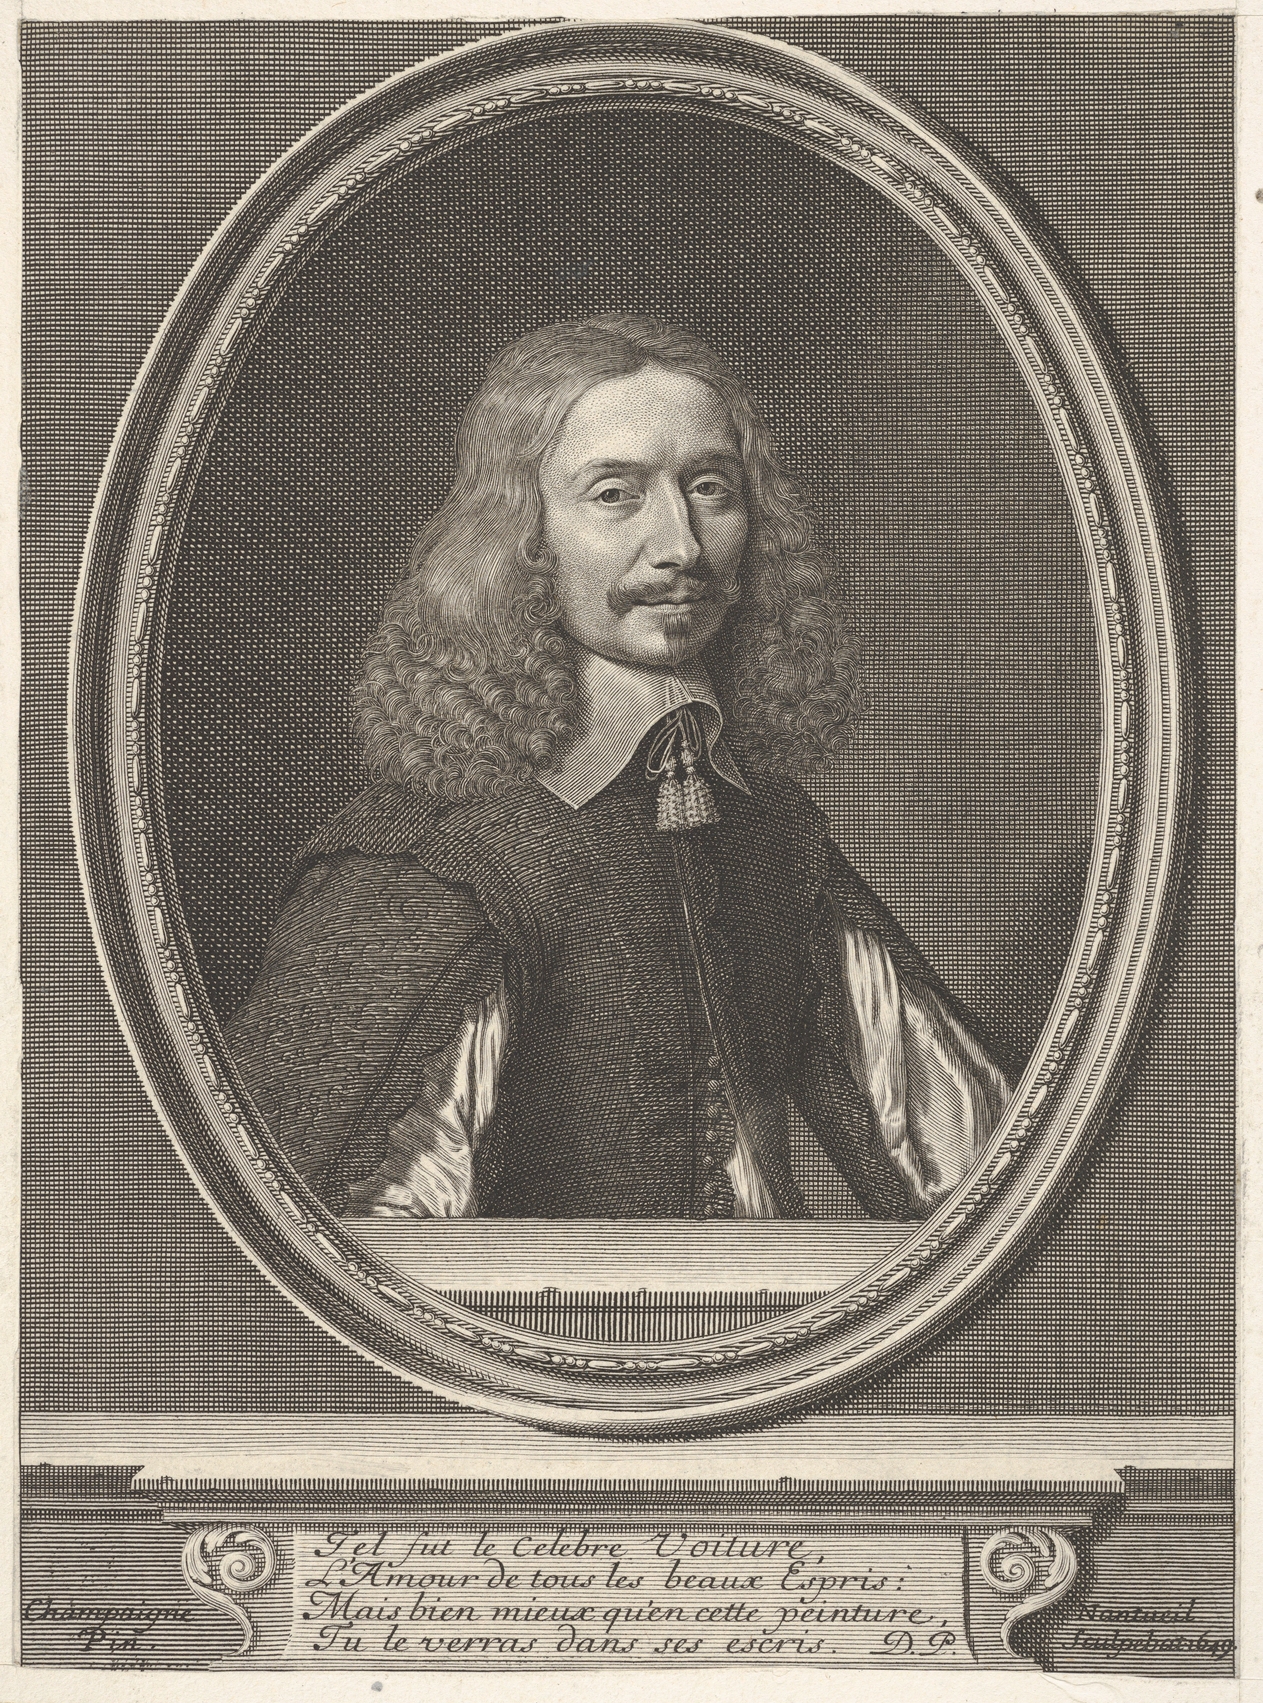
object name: print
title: Vincent Voiture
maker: robert nanteuil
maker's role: artist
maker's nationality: french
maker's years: 1623-1678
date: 1649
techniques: engraving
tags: men,portraits